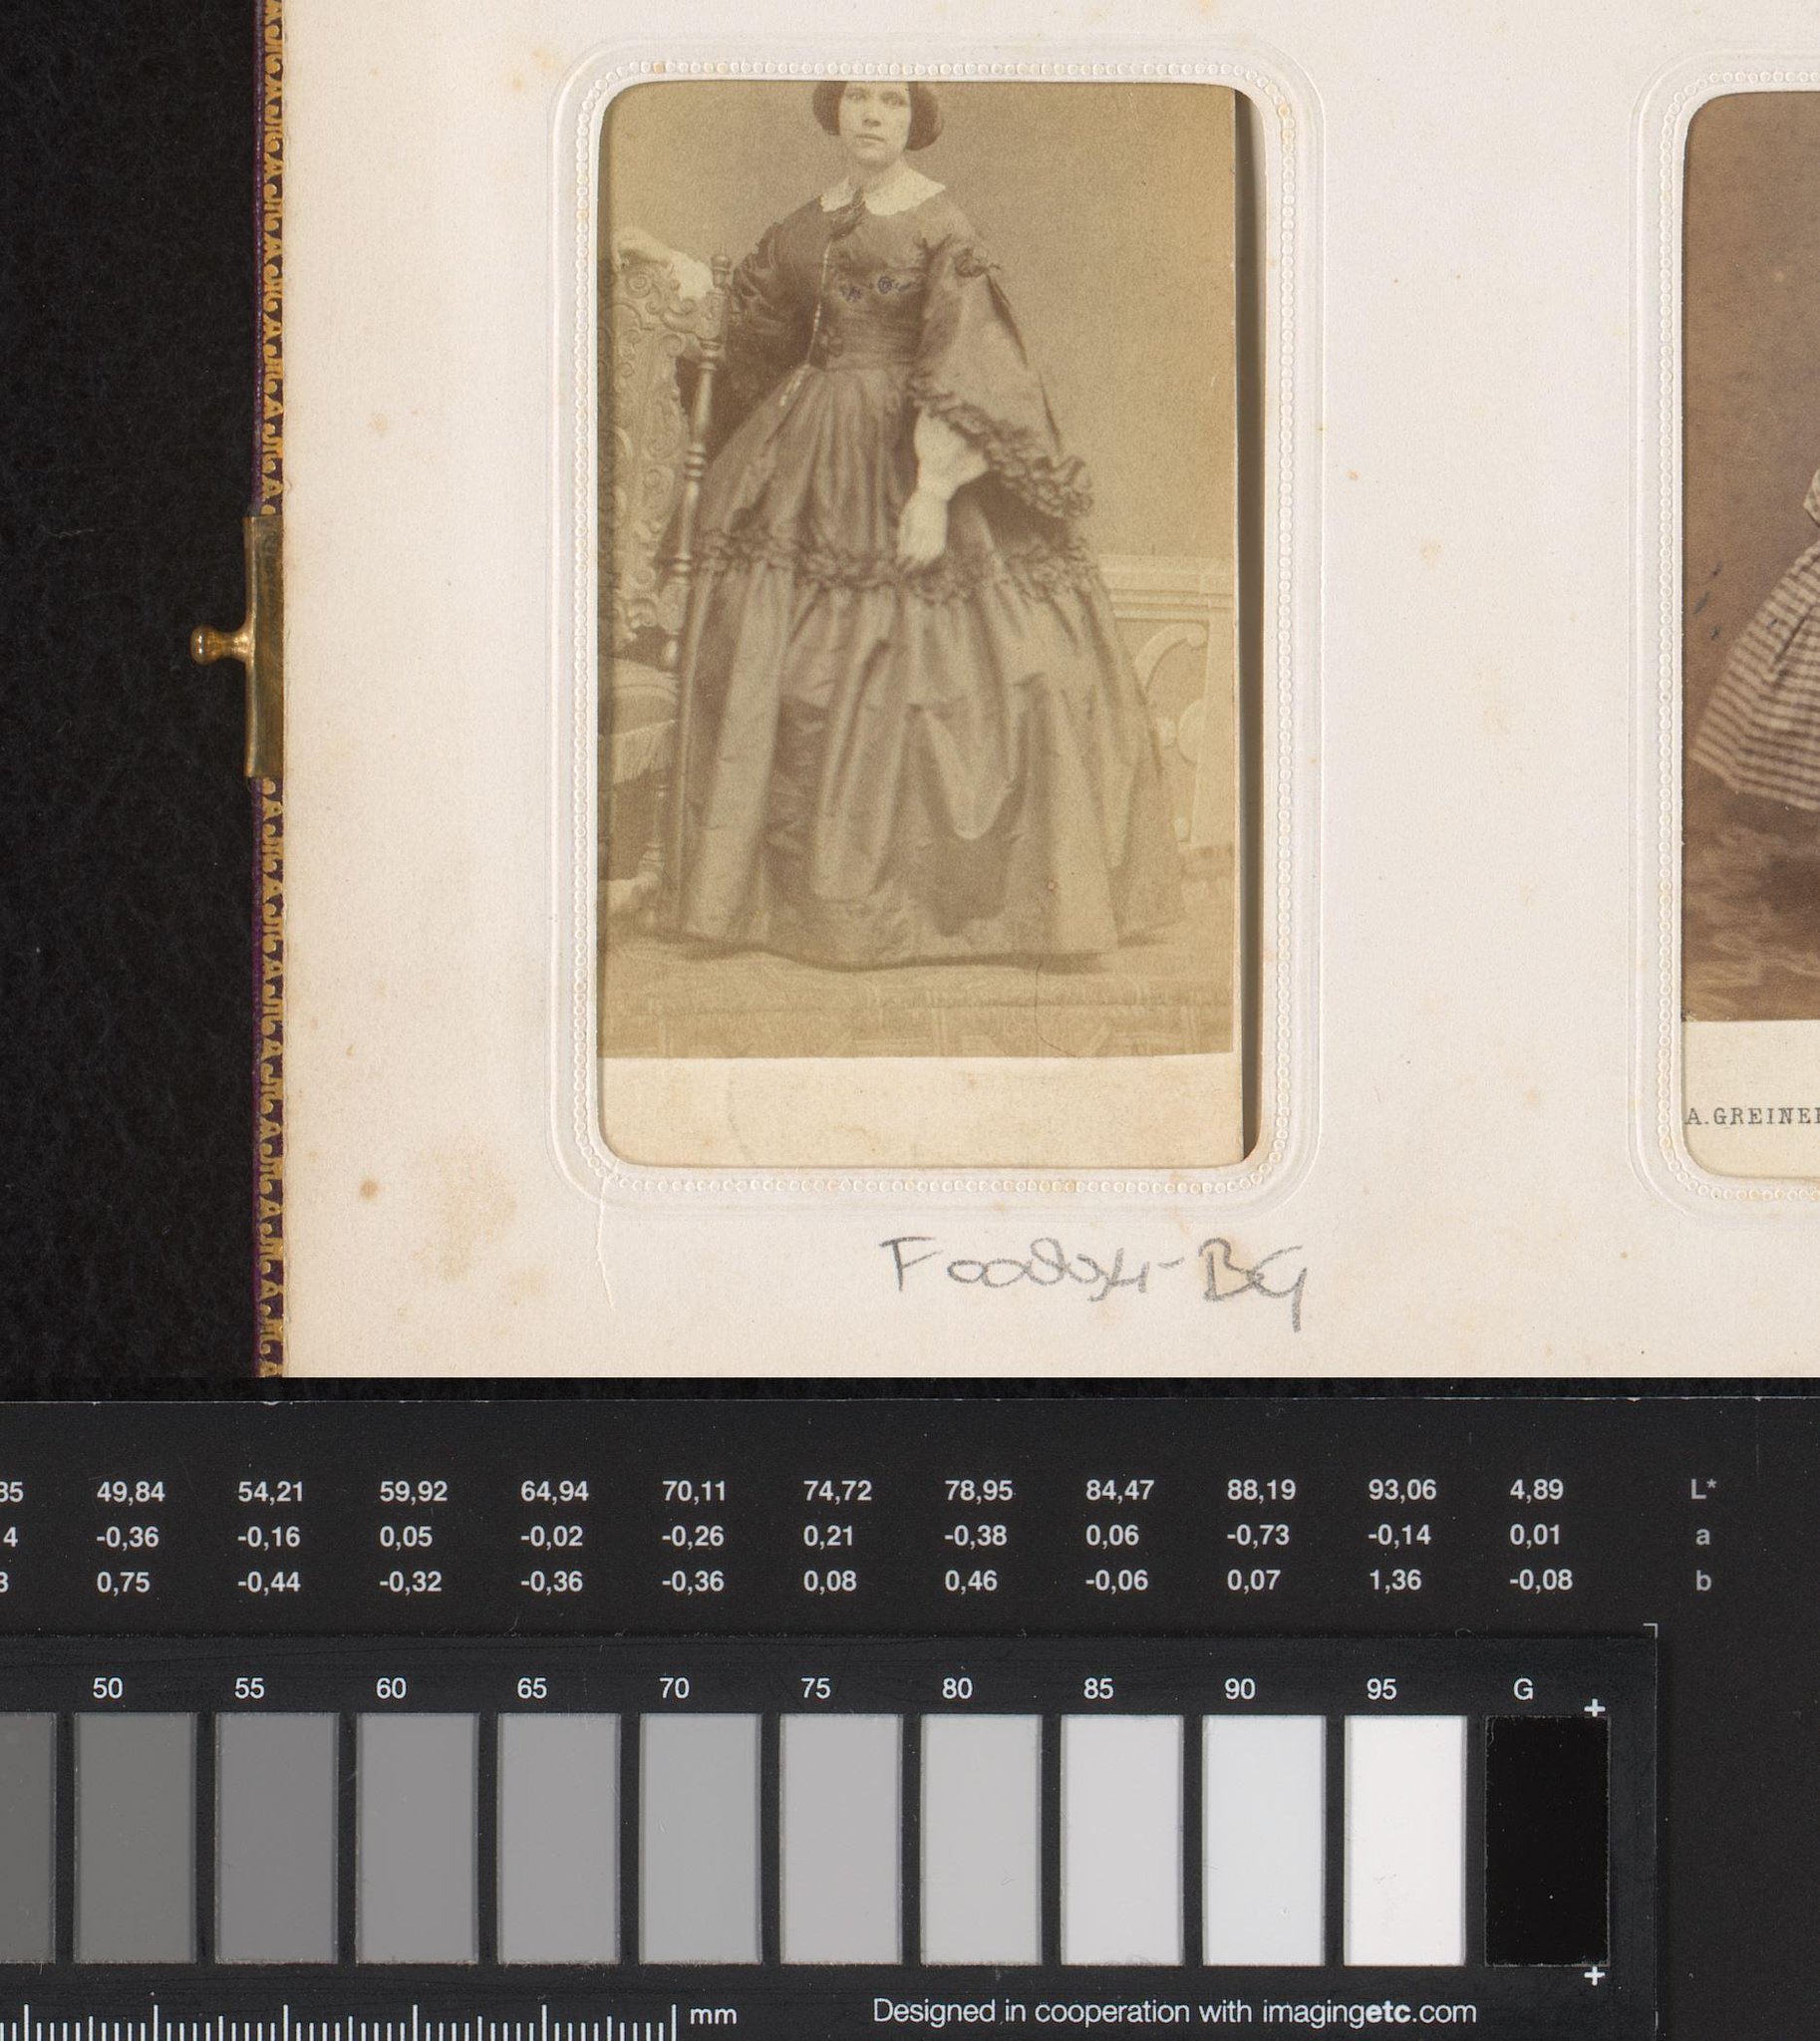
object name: carte de visite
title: Portret van een vrouw, staand bij stoel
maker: hendrik gerbens de boer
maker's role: fotograaf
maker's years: 1800-1865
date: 1855-1865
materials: cardboard, photographic support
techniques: albumen print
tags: historical persons, standing figure - aa - female human figure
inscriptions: inscription: ‘H.G. de Boer/ Photographe’